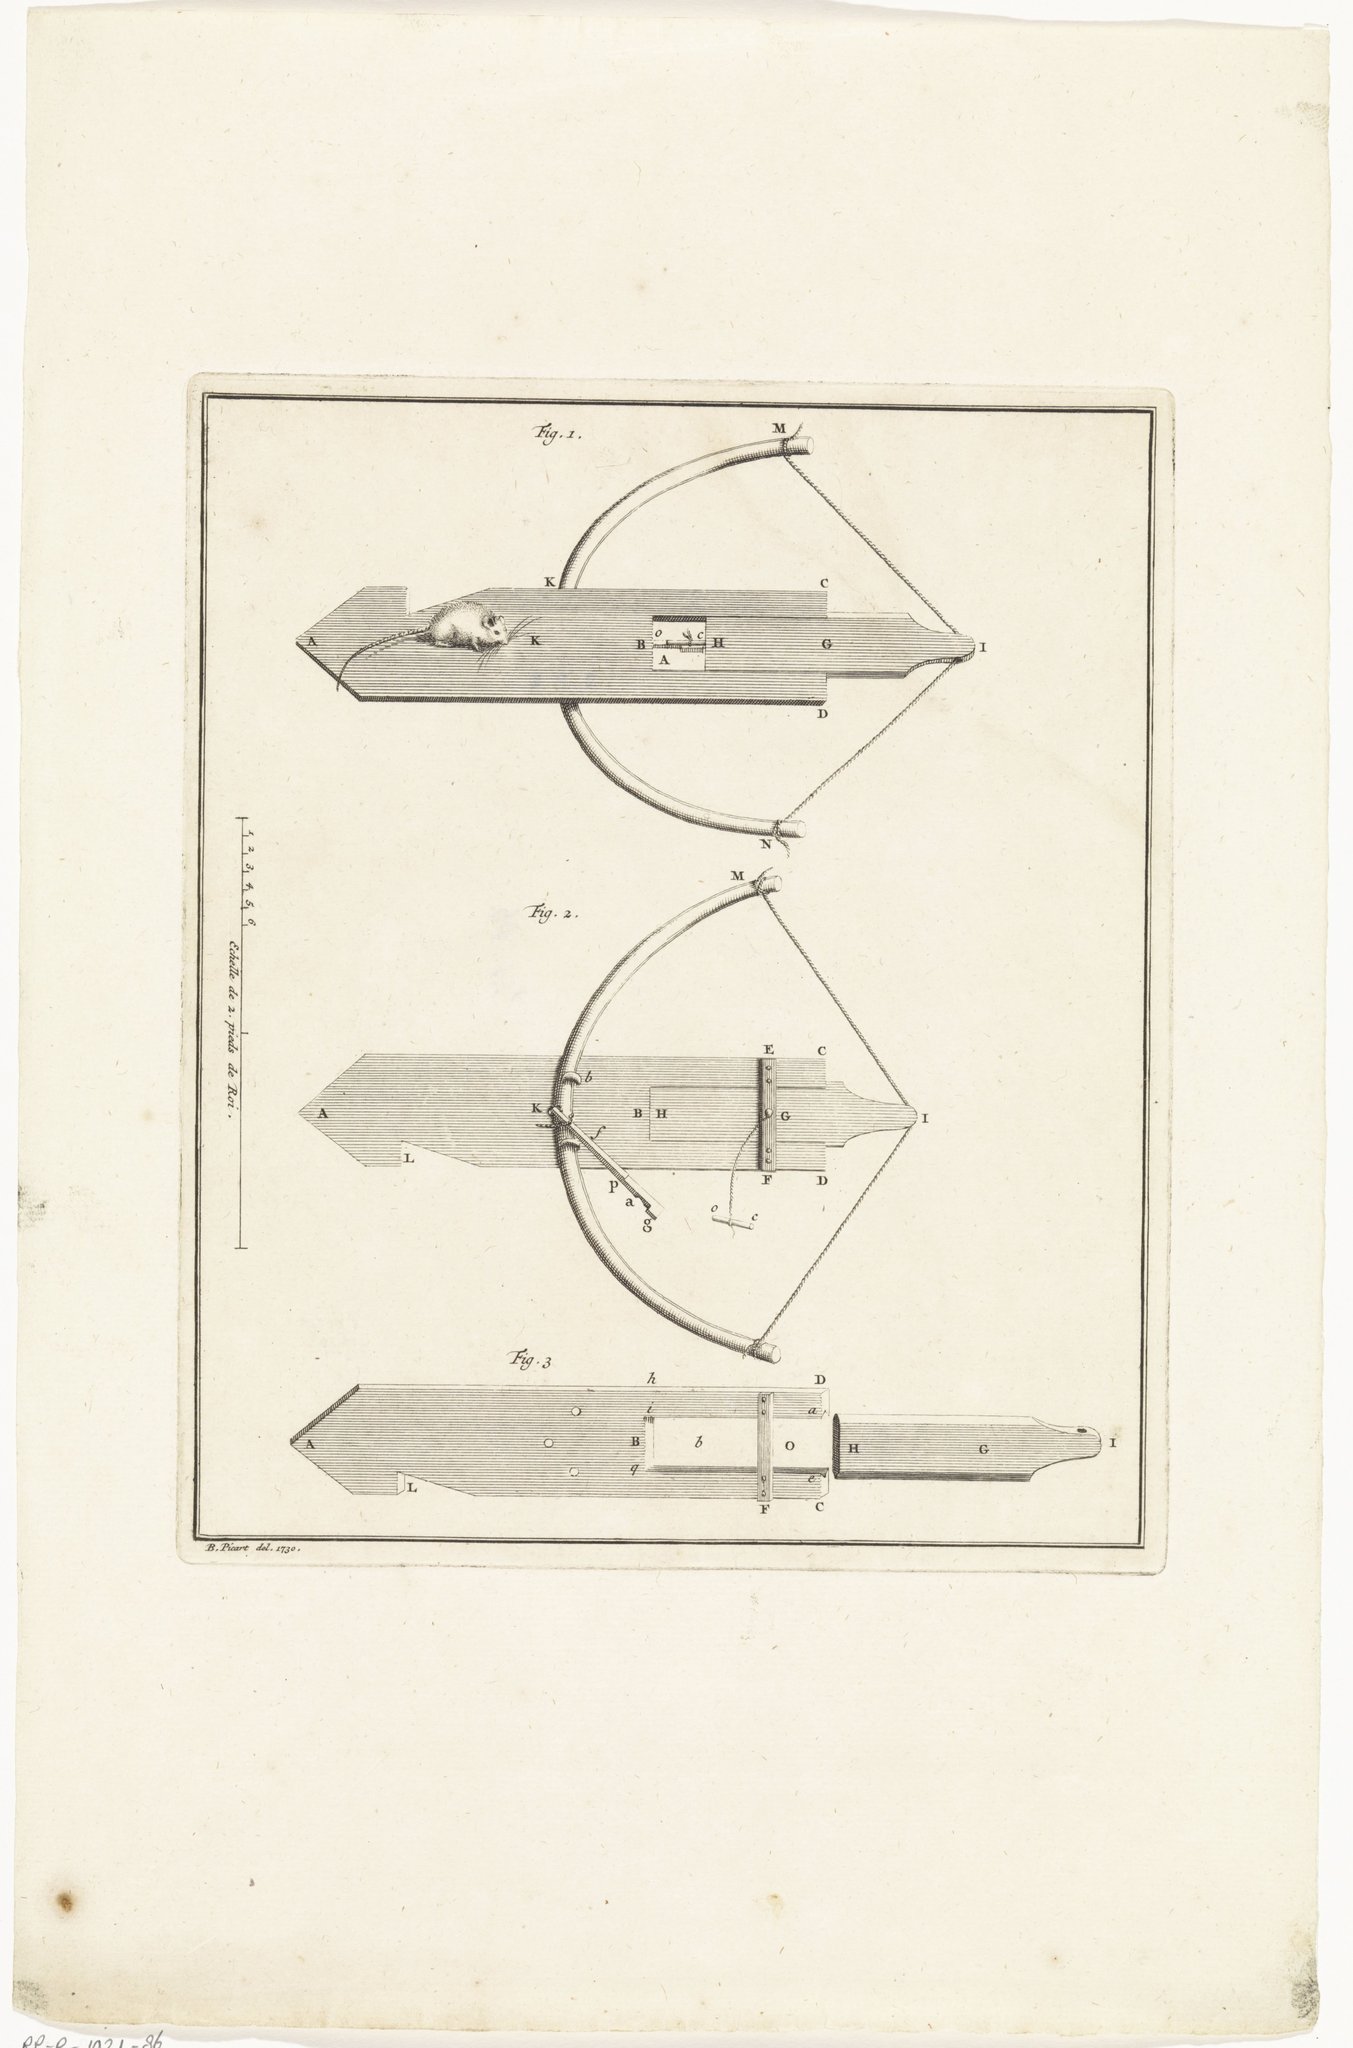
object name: book illustration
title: Constructie van een muizenval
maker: bernard picart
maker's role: draughtsman, print maker, publisher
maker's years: 1673-1733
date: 1730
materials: paper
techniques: etching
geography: amsterdam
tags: mouse trap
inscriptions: collector's mark: Lugt 2233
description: Prent bedoeld voor: Chomel, Noel. Dictionnaire oeconomique, contenant divers moïens d'augmenter son bien, et de conserver sa santé. Amsterdam: Johannes Covens en Cornelis Mortier, 1732.